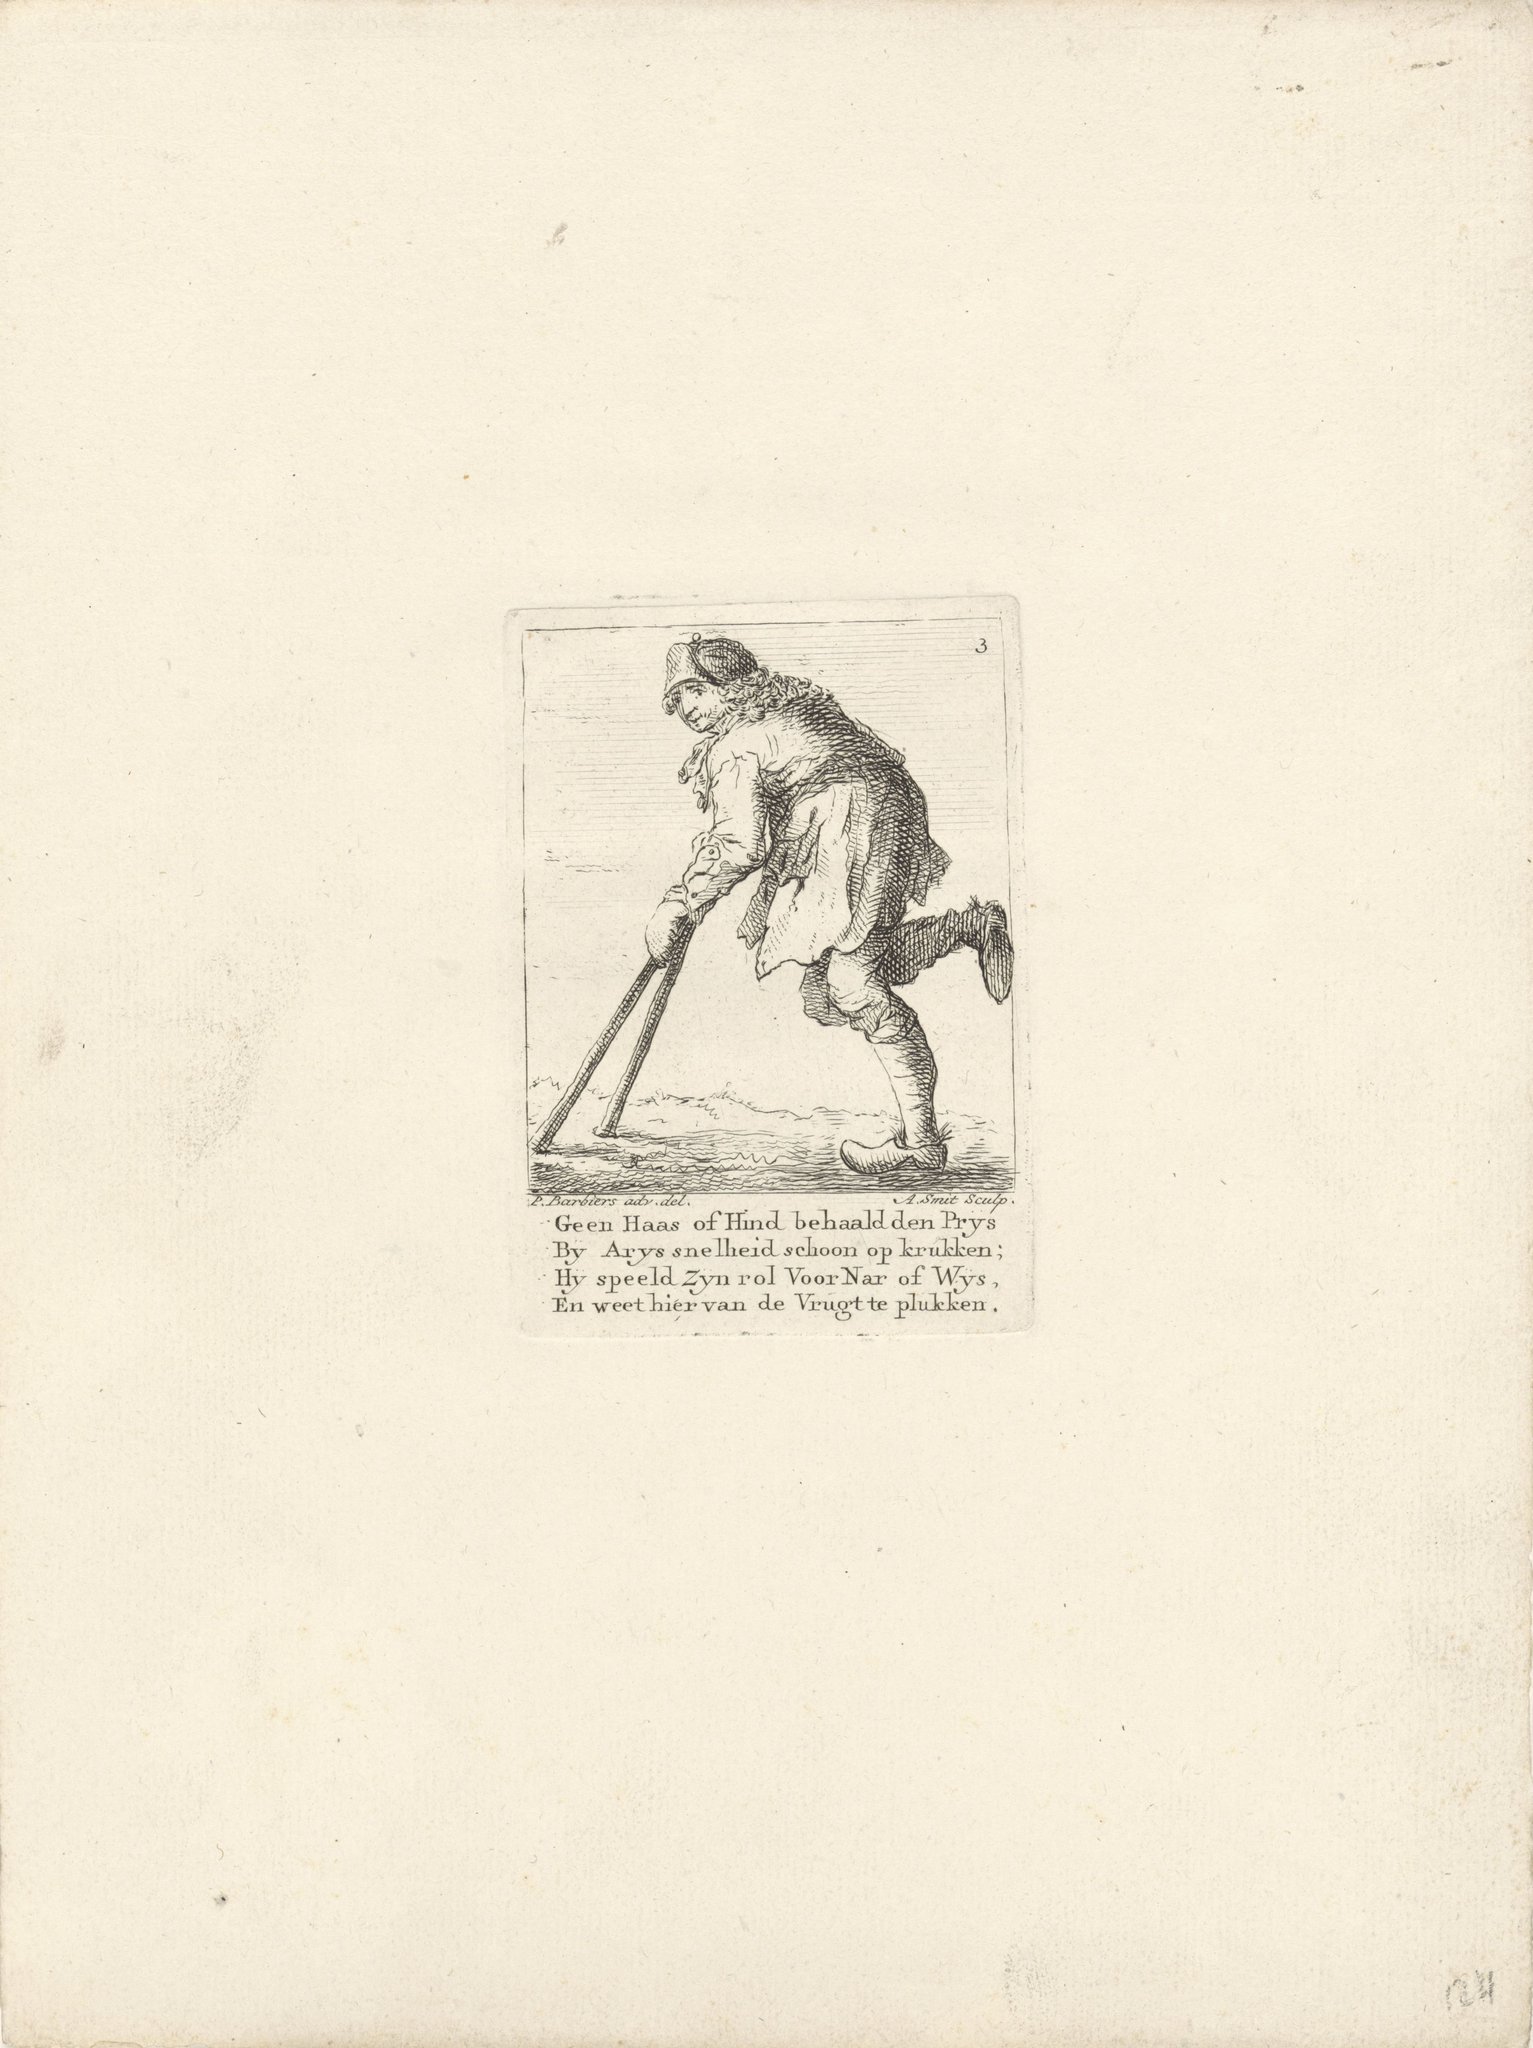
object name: print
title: Bedelaar op krukken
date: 1764-1792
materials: paper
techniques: engraving, etching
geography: amsterdam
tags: crutches, beggar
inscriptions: collector's mark: Lugt 2228, collector's mark: ‘Pvd V 124’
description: Een bedelaar op klompen met krukken. Onder de prent vier versregels in het Nederlands.